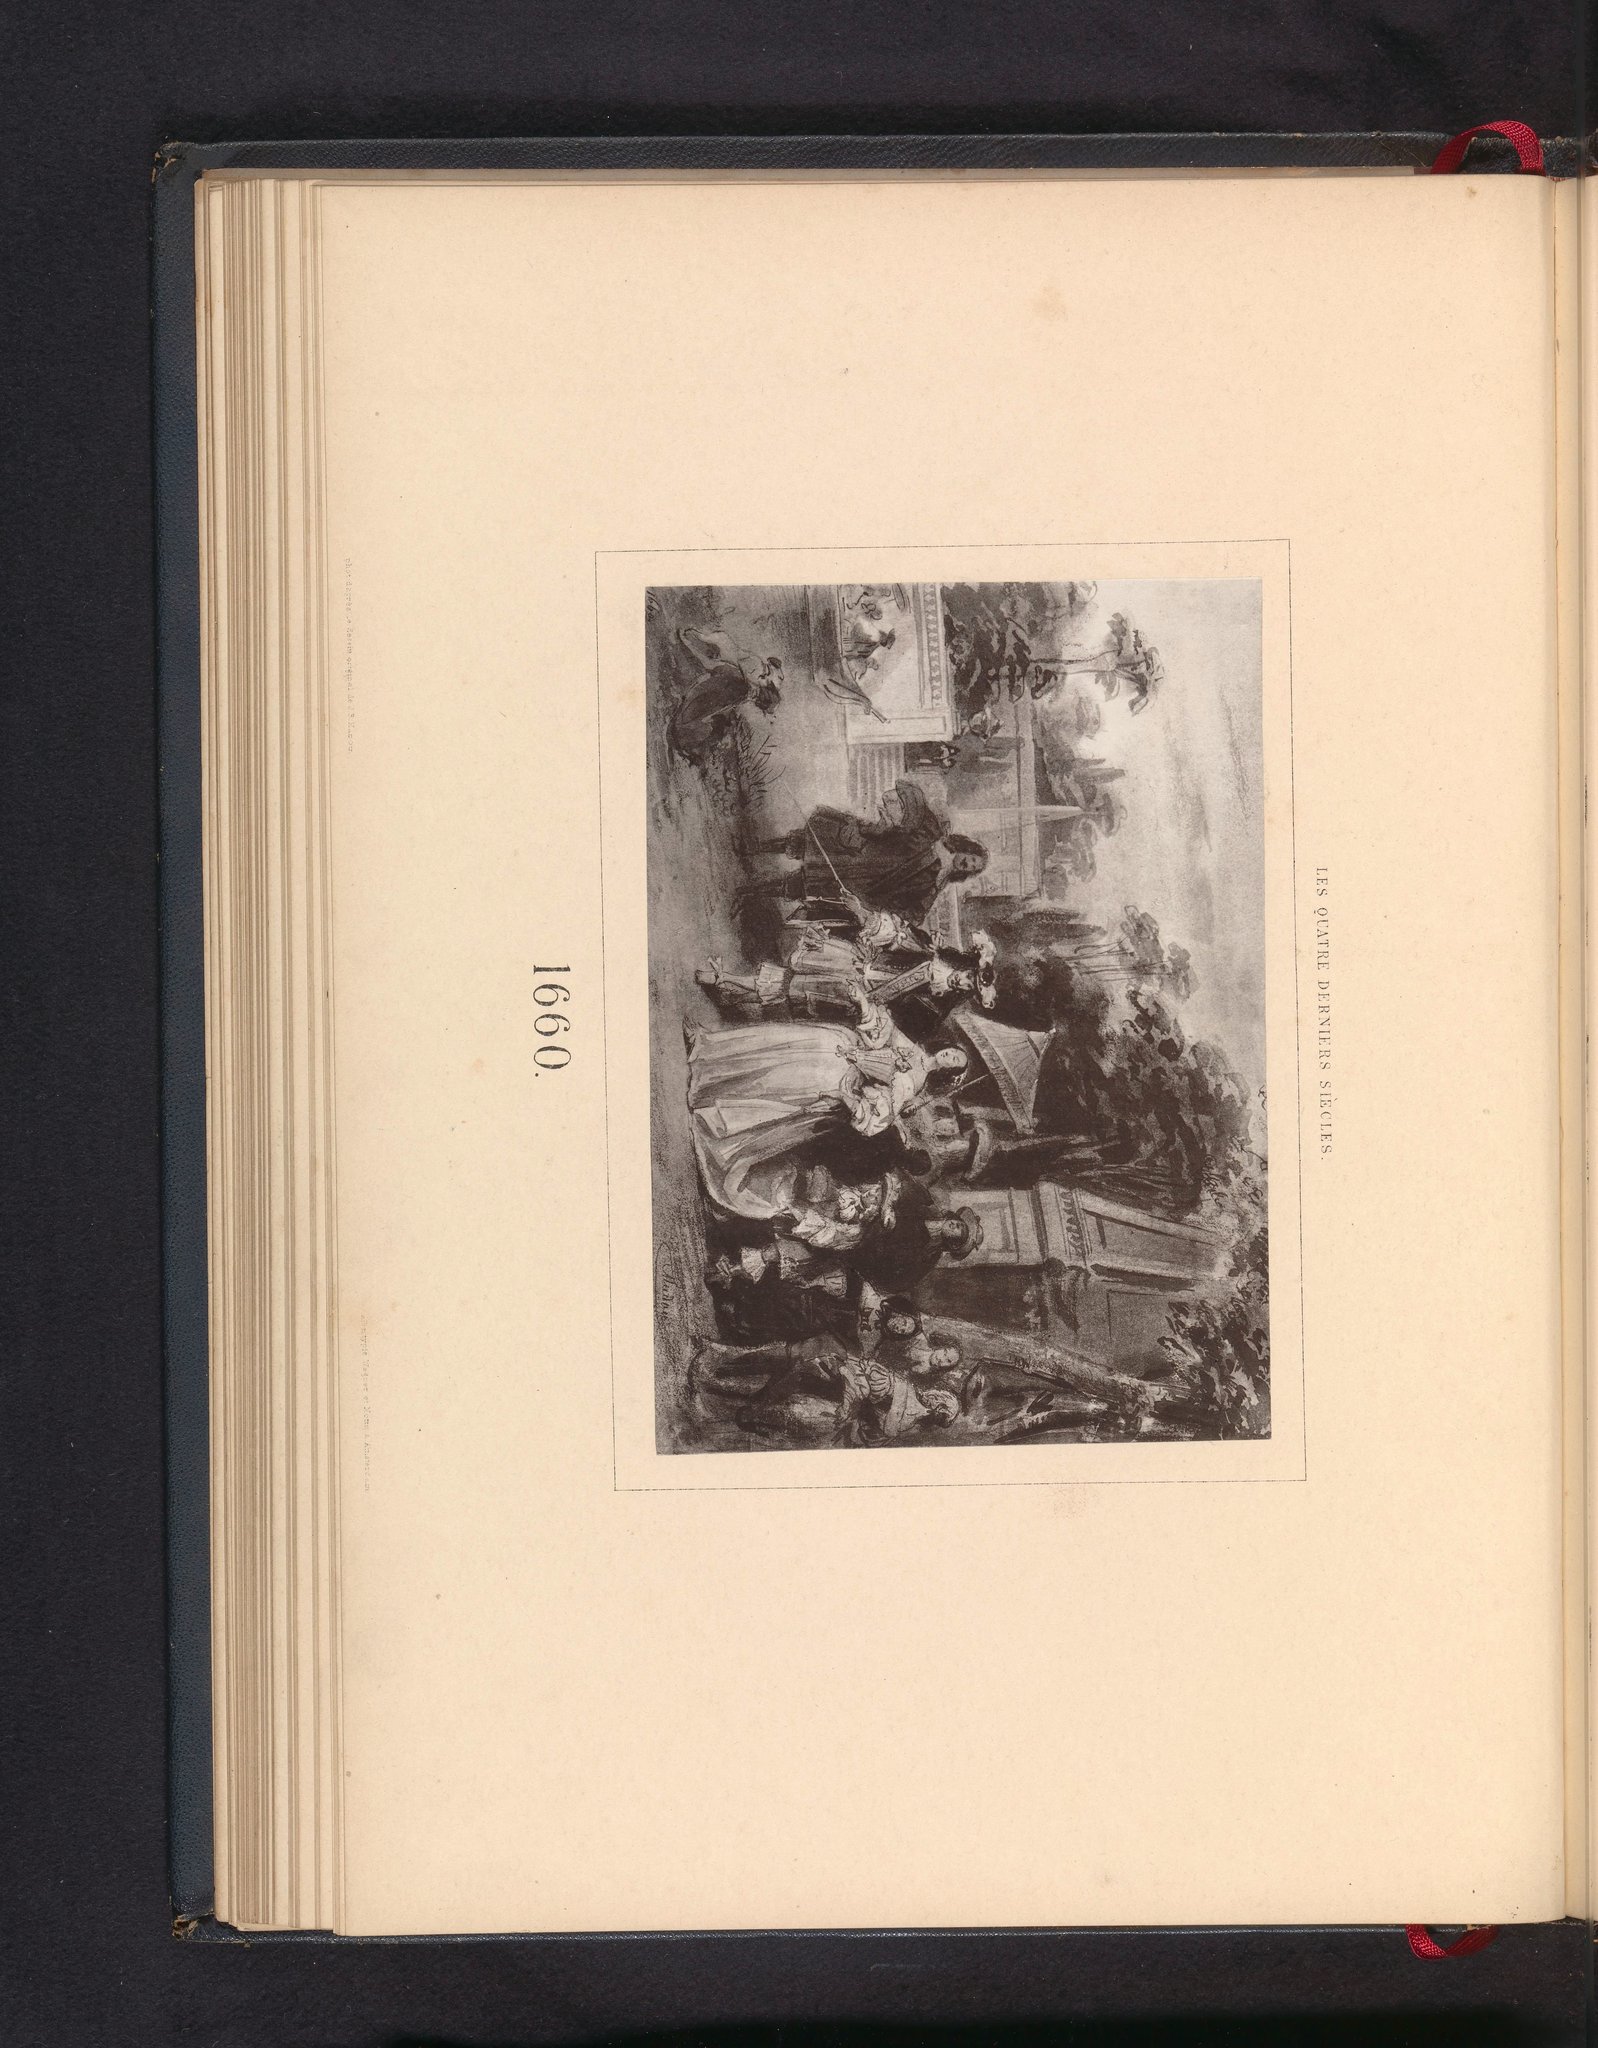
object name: reproduction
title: 1660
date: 1868-1873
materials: paper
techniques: photograph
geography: amsterdam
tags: garden, nobility and patriciate; chivalry, knighthood